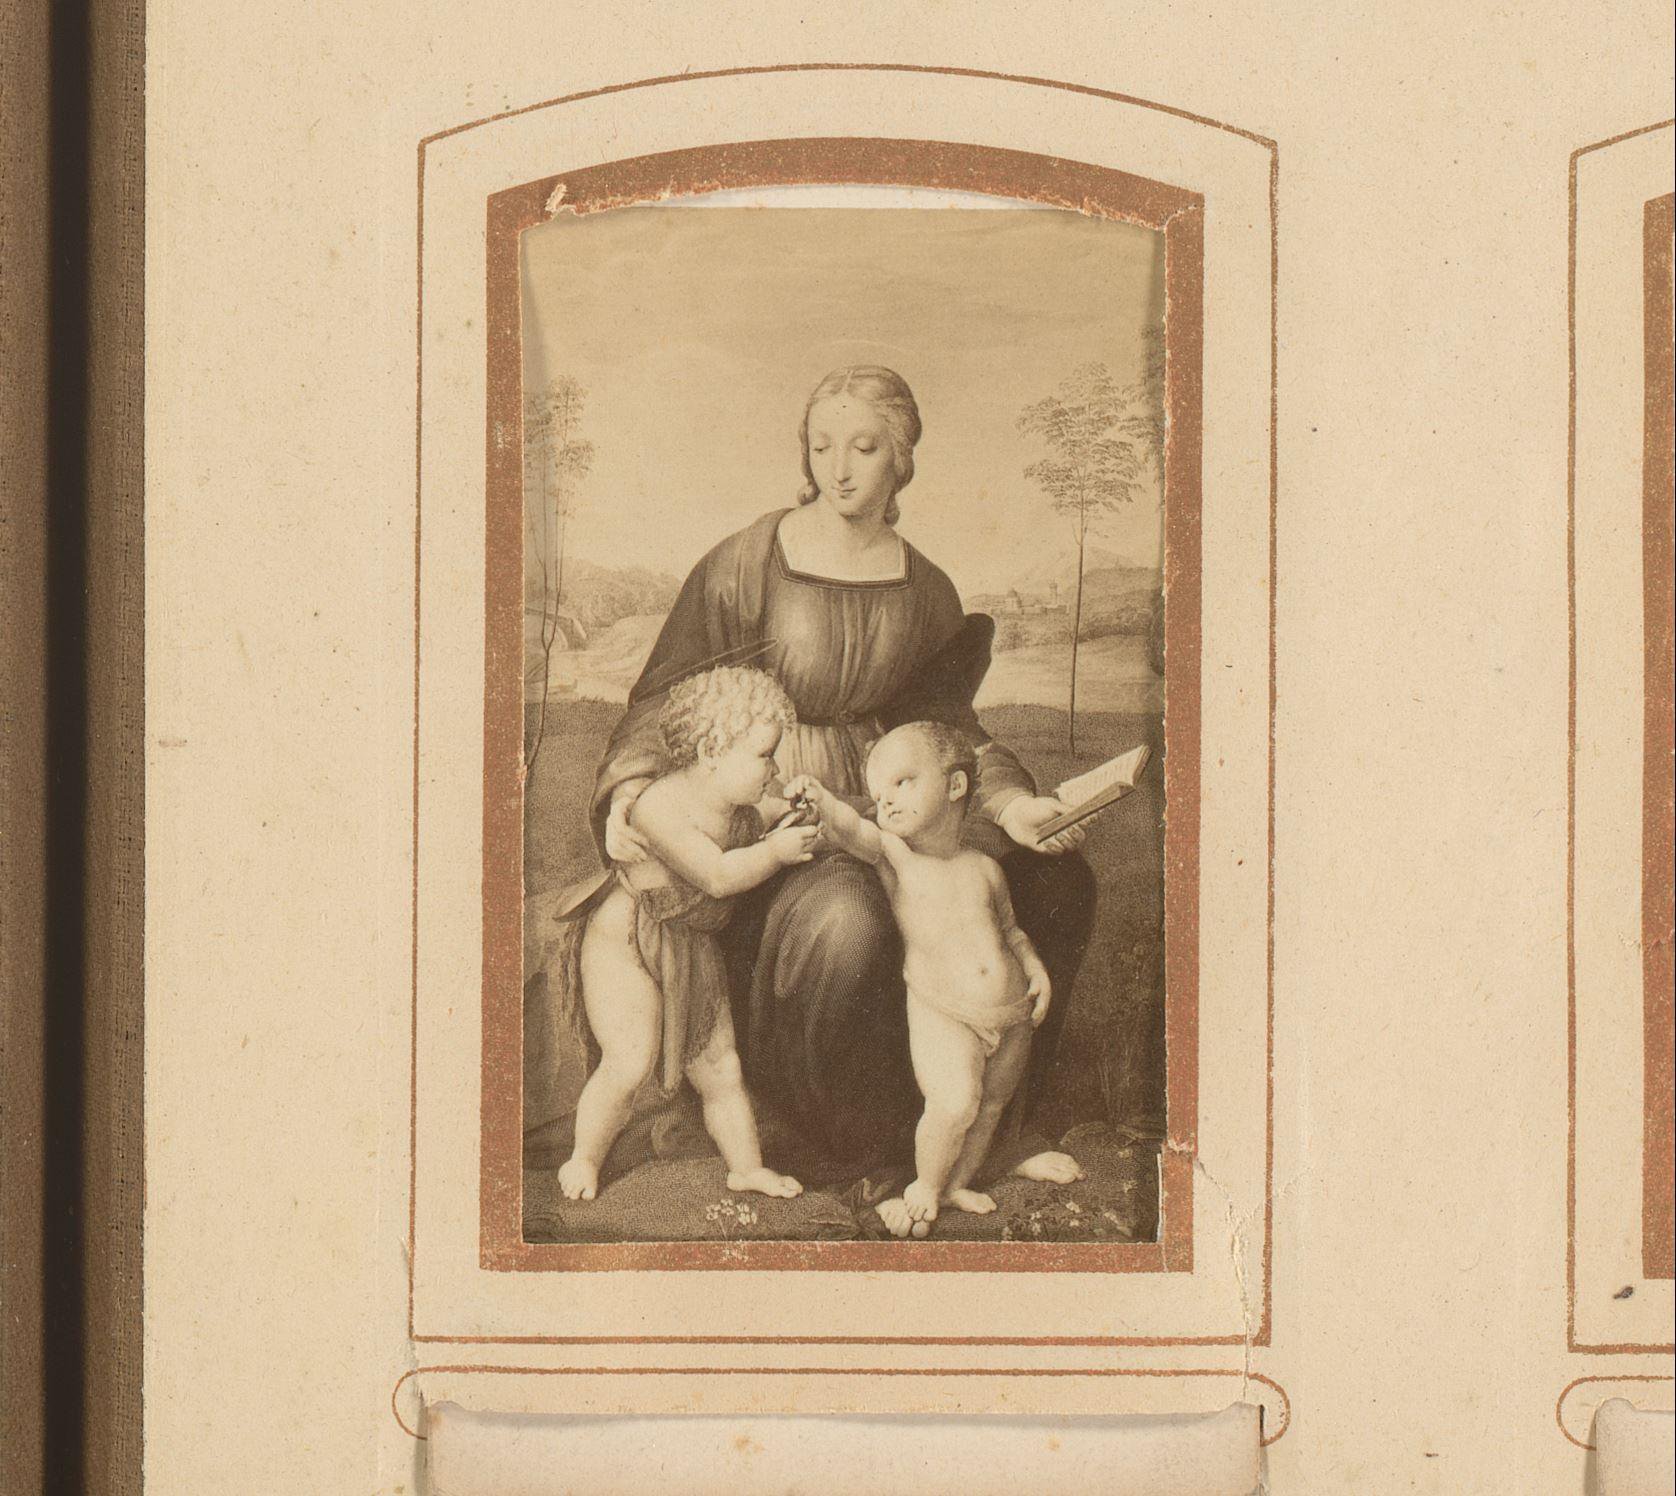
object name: album leaf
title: Fotoreproductie van Madonna met het puttertje door Rafaël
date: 1850-1900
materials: cardboard, photographic support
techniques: albumen print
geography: berlin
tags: madonna: i.e. mary with the christ-child, song-birds: goldfinch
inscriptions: inscription: ‘Rafael:/ La vierge à l'oiseau./ 350.’, inscription: ‘Gustav Schauer/ Photographisches Kunst- und Verlags - Institut/ BERLIN/ Grosse Friedrichs - Strasse 188.’